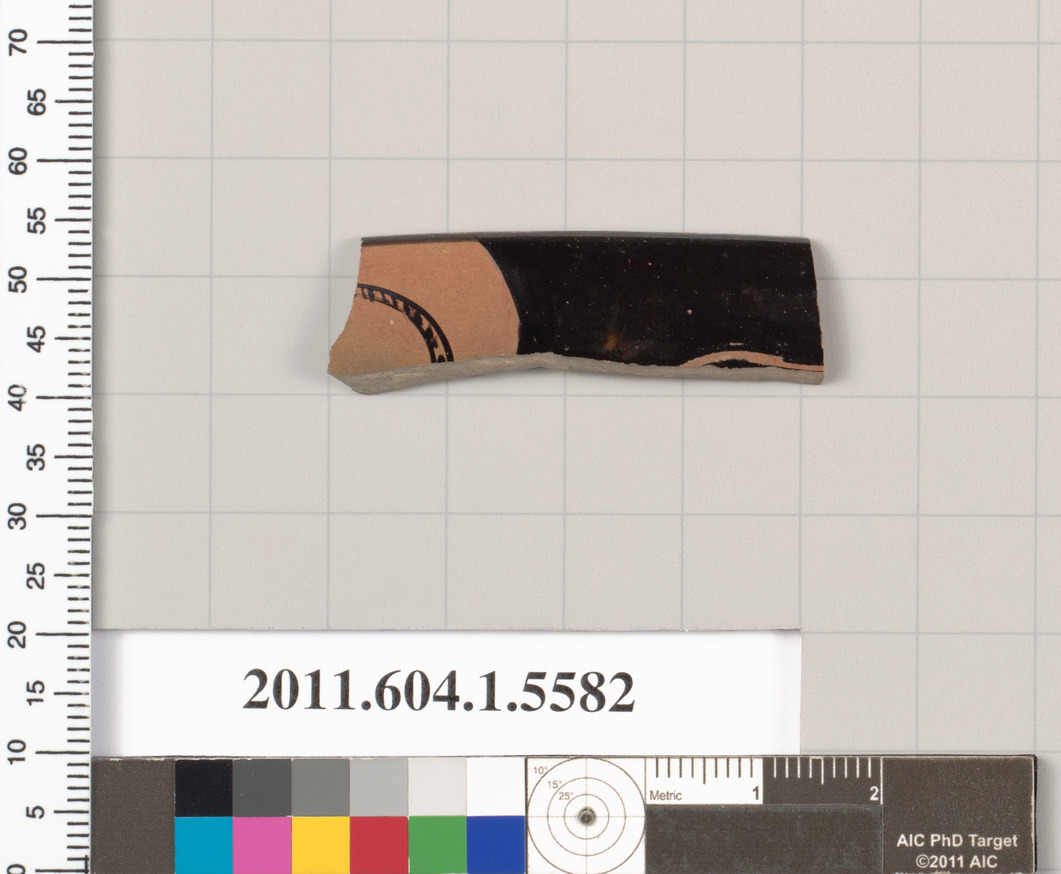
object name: kylix fragment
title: Terracotta rim fragment of a kylix (drinking cup)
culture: greek, attic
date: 500-490 BCE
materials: terracotta